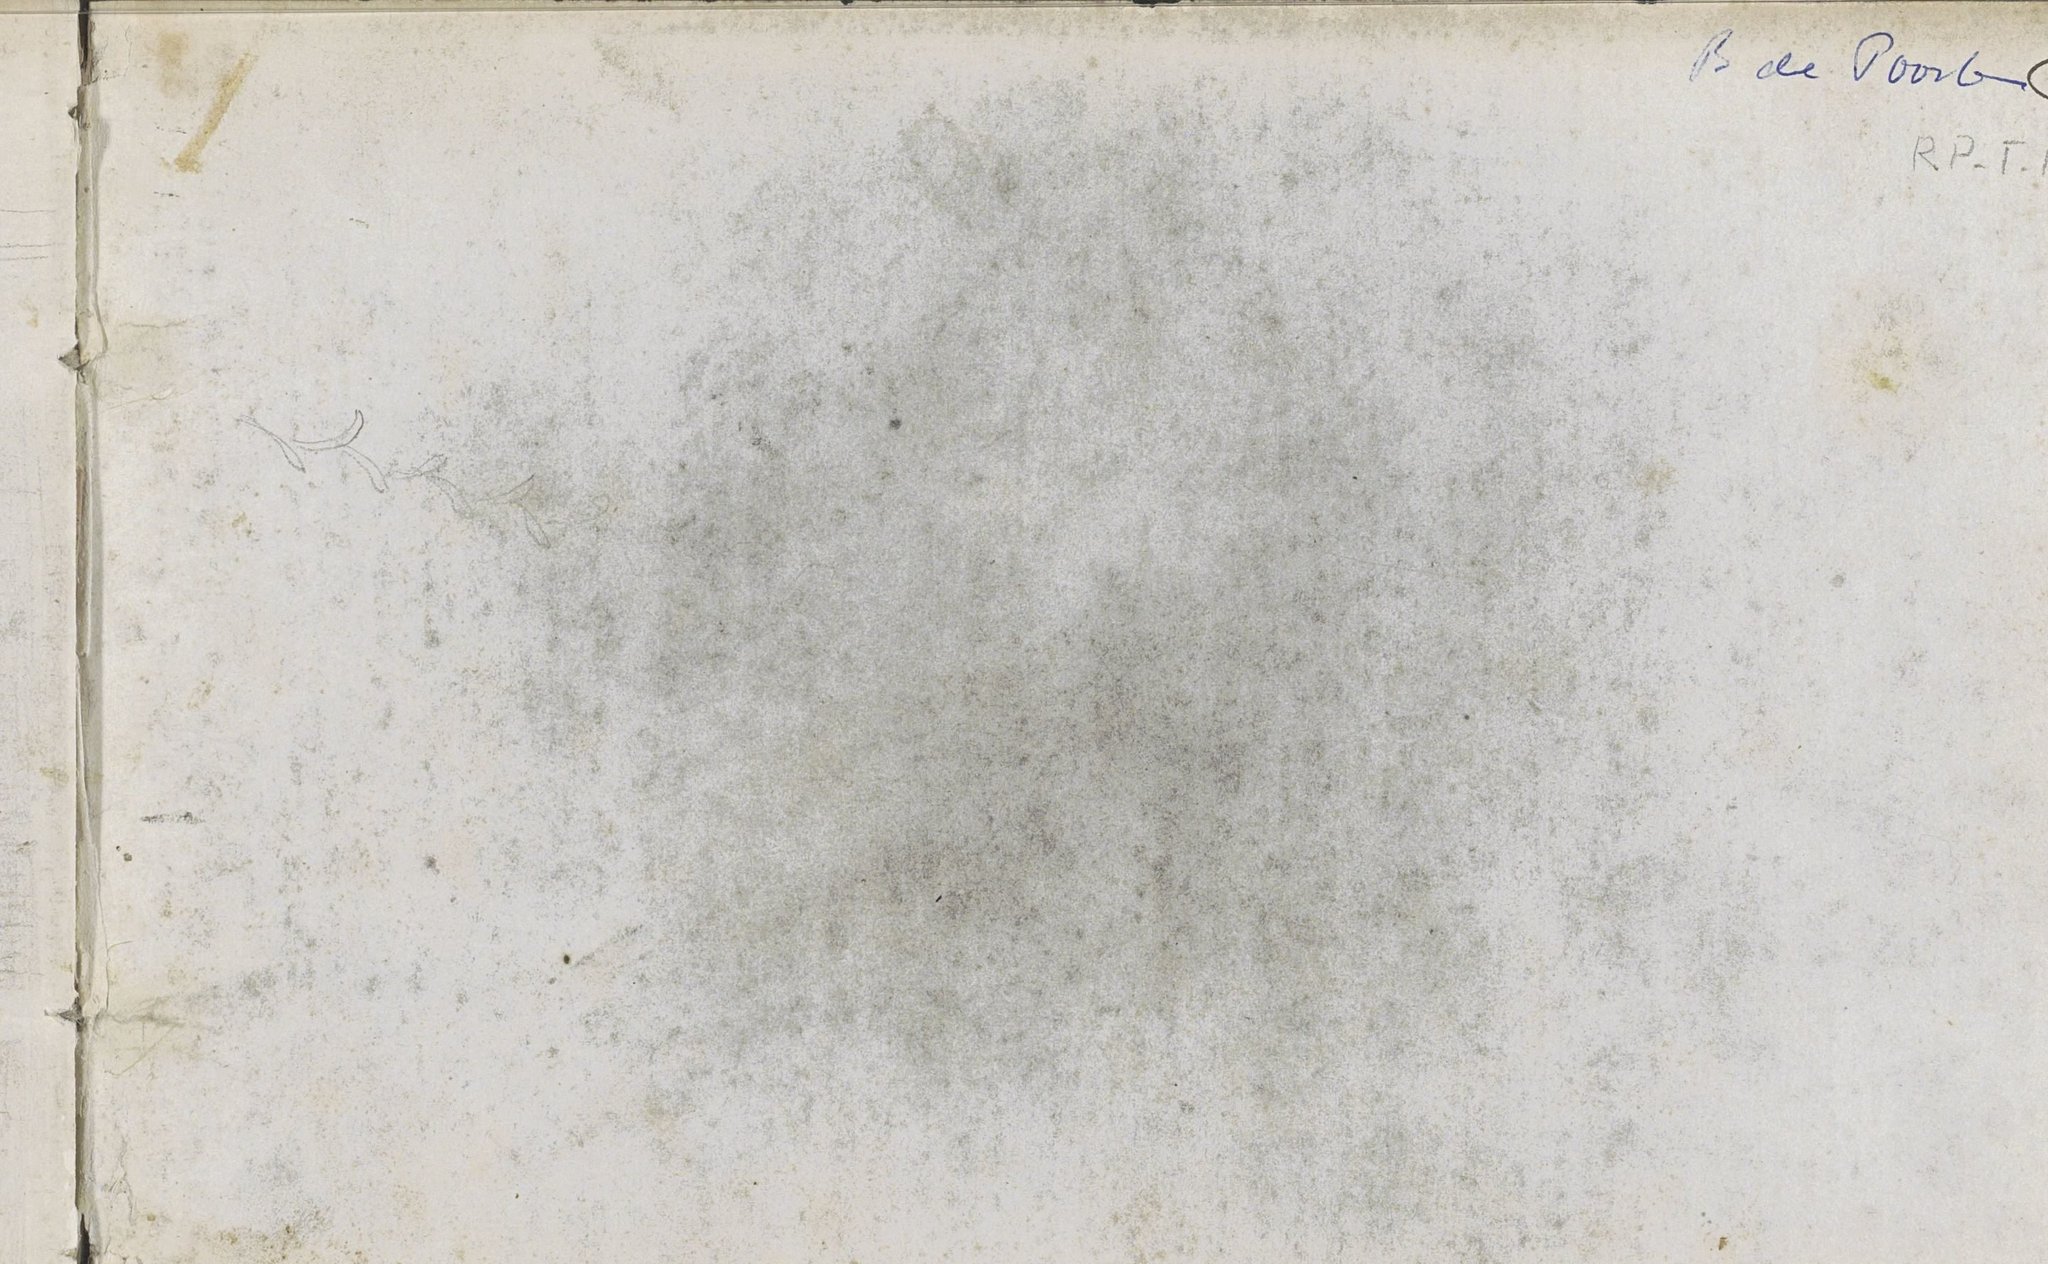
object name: sketchbook leaf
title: Tak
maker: bastiaan de poorter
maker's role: painter, print maker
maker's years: 1813-1880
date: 1858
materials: paper, pencil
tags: trees (+ branch, stick)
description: Achterste schutblad uit een gecombineerd album amicorum en schetsboek met in totaal 39 bladen.